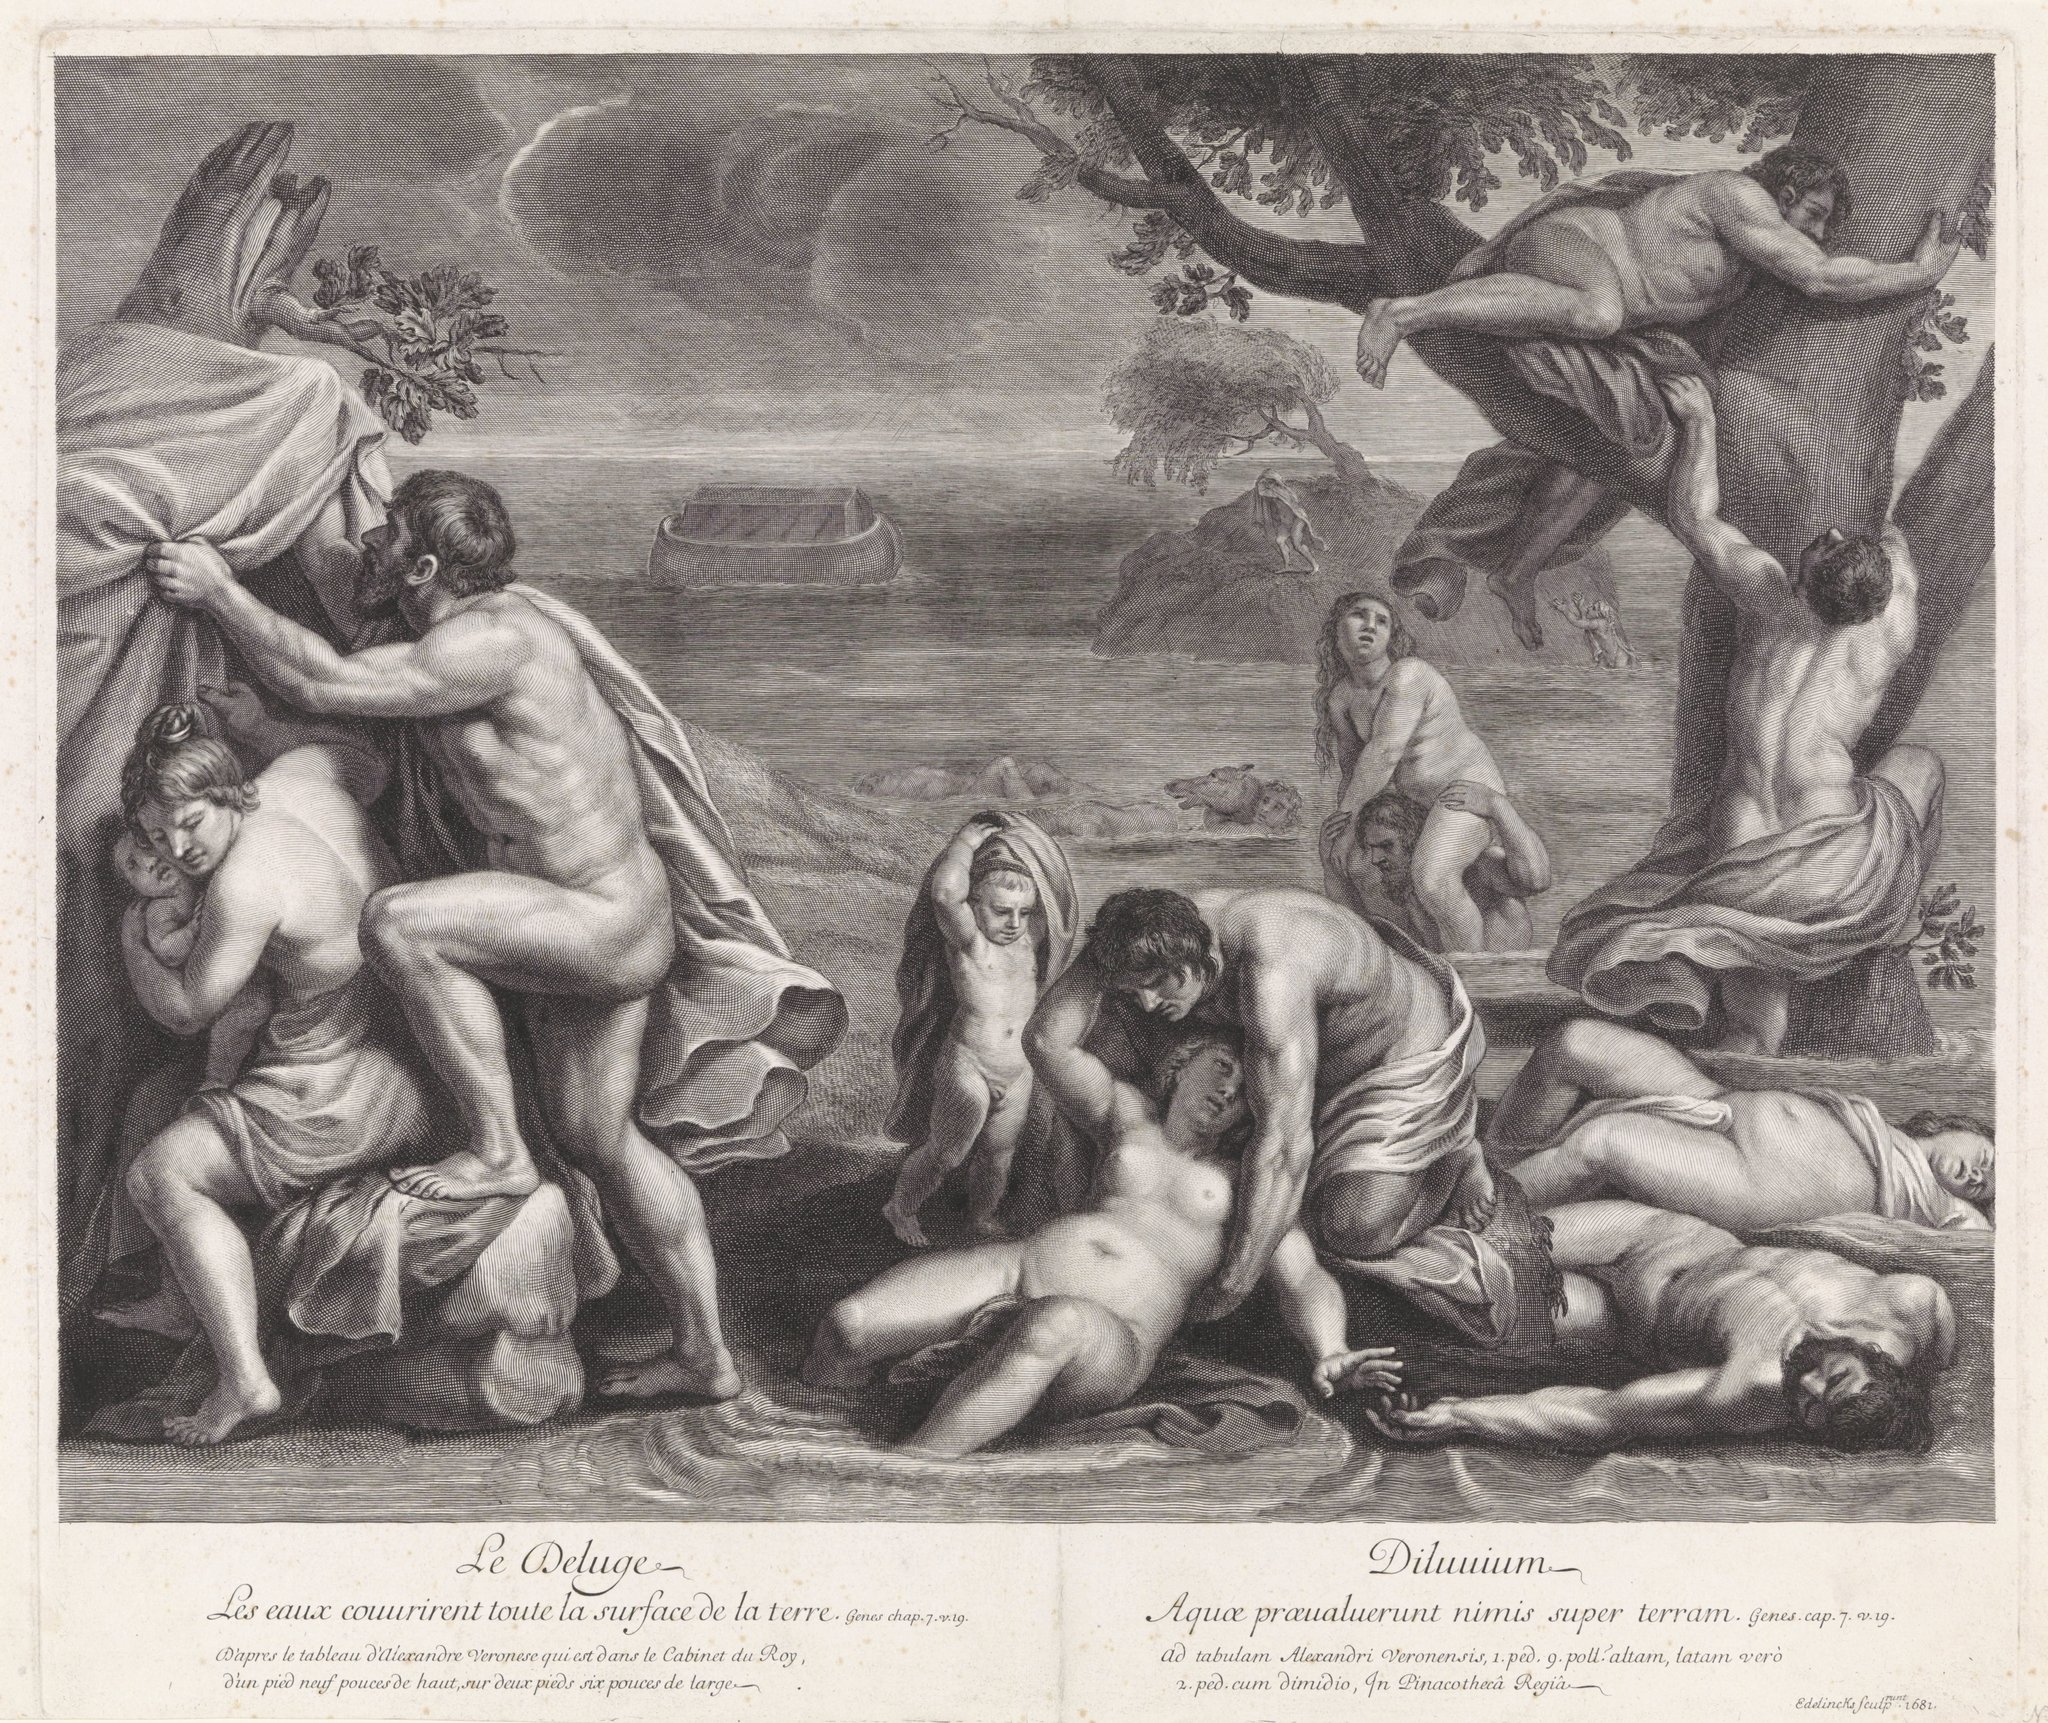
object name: print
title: Le Deluge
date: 1681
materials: paper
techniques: engraving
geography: netherlands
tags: the flood and destruction of mankind ~ story of noah (genesis 7:10 - 8:17)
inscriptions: collector's mark: Lugt 240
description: Naakte mannen, vrouwen en kinderen proberen aan het stromende water te ontkomen door in een boom of op hoger gelegen delen te klimmen. Enkelen liggen levenloos in het water. Op de achtergrond vaart de ark van Noach. Onder de voorstelling vier regels in het Frans en vier in Latijn.